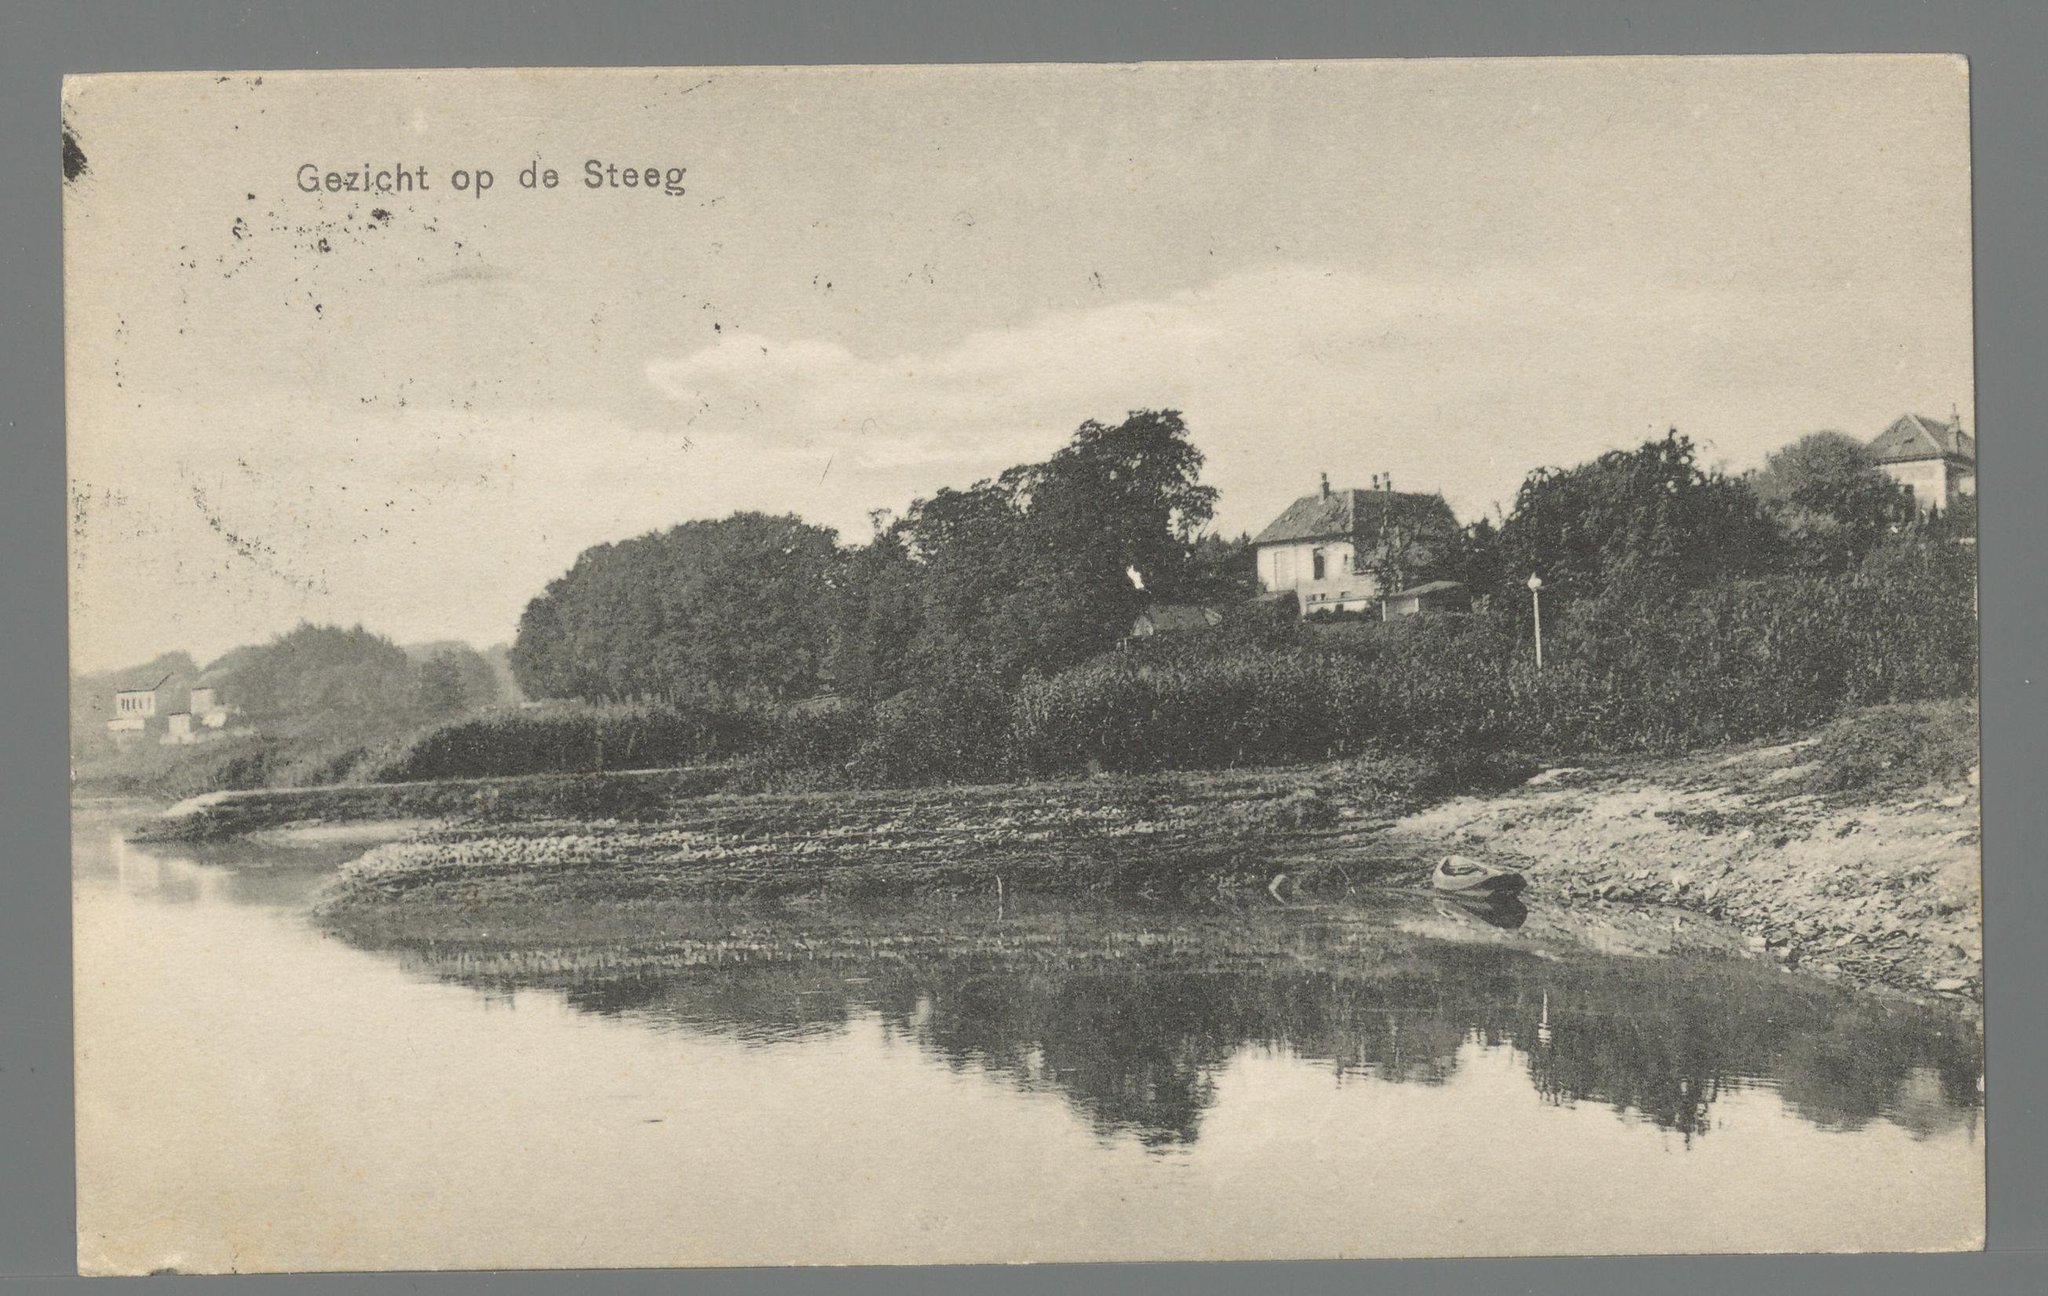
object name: photomechanical print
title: Gezicht op de Steeg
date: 1909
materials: cardboard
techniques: photograph, writing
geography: de steeg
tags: city-view, and landscape with man-made constructions, river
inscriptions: postage stamp